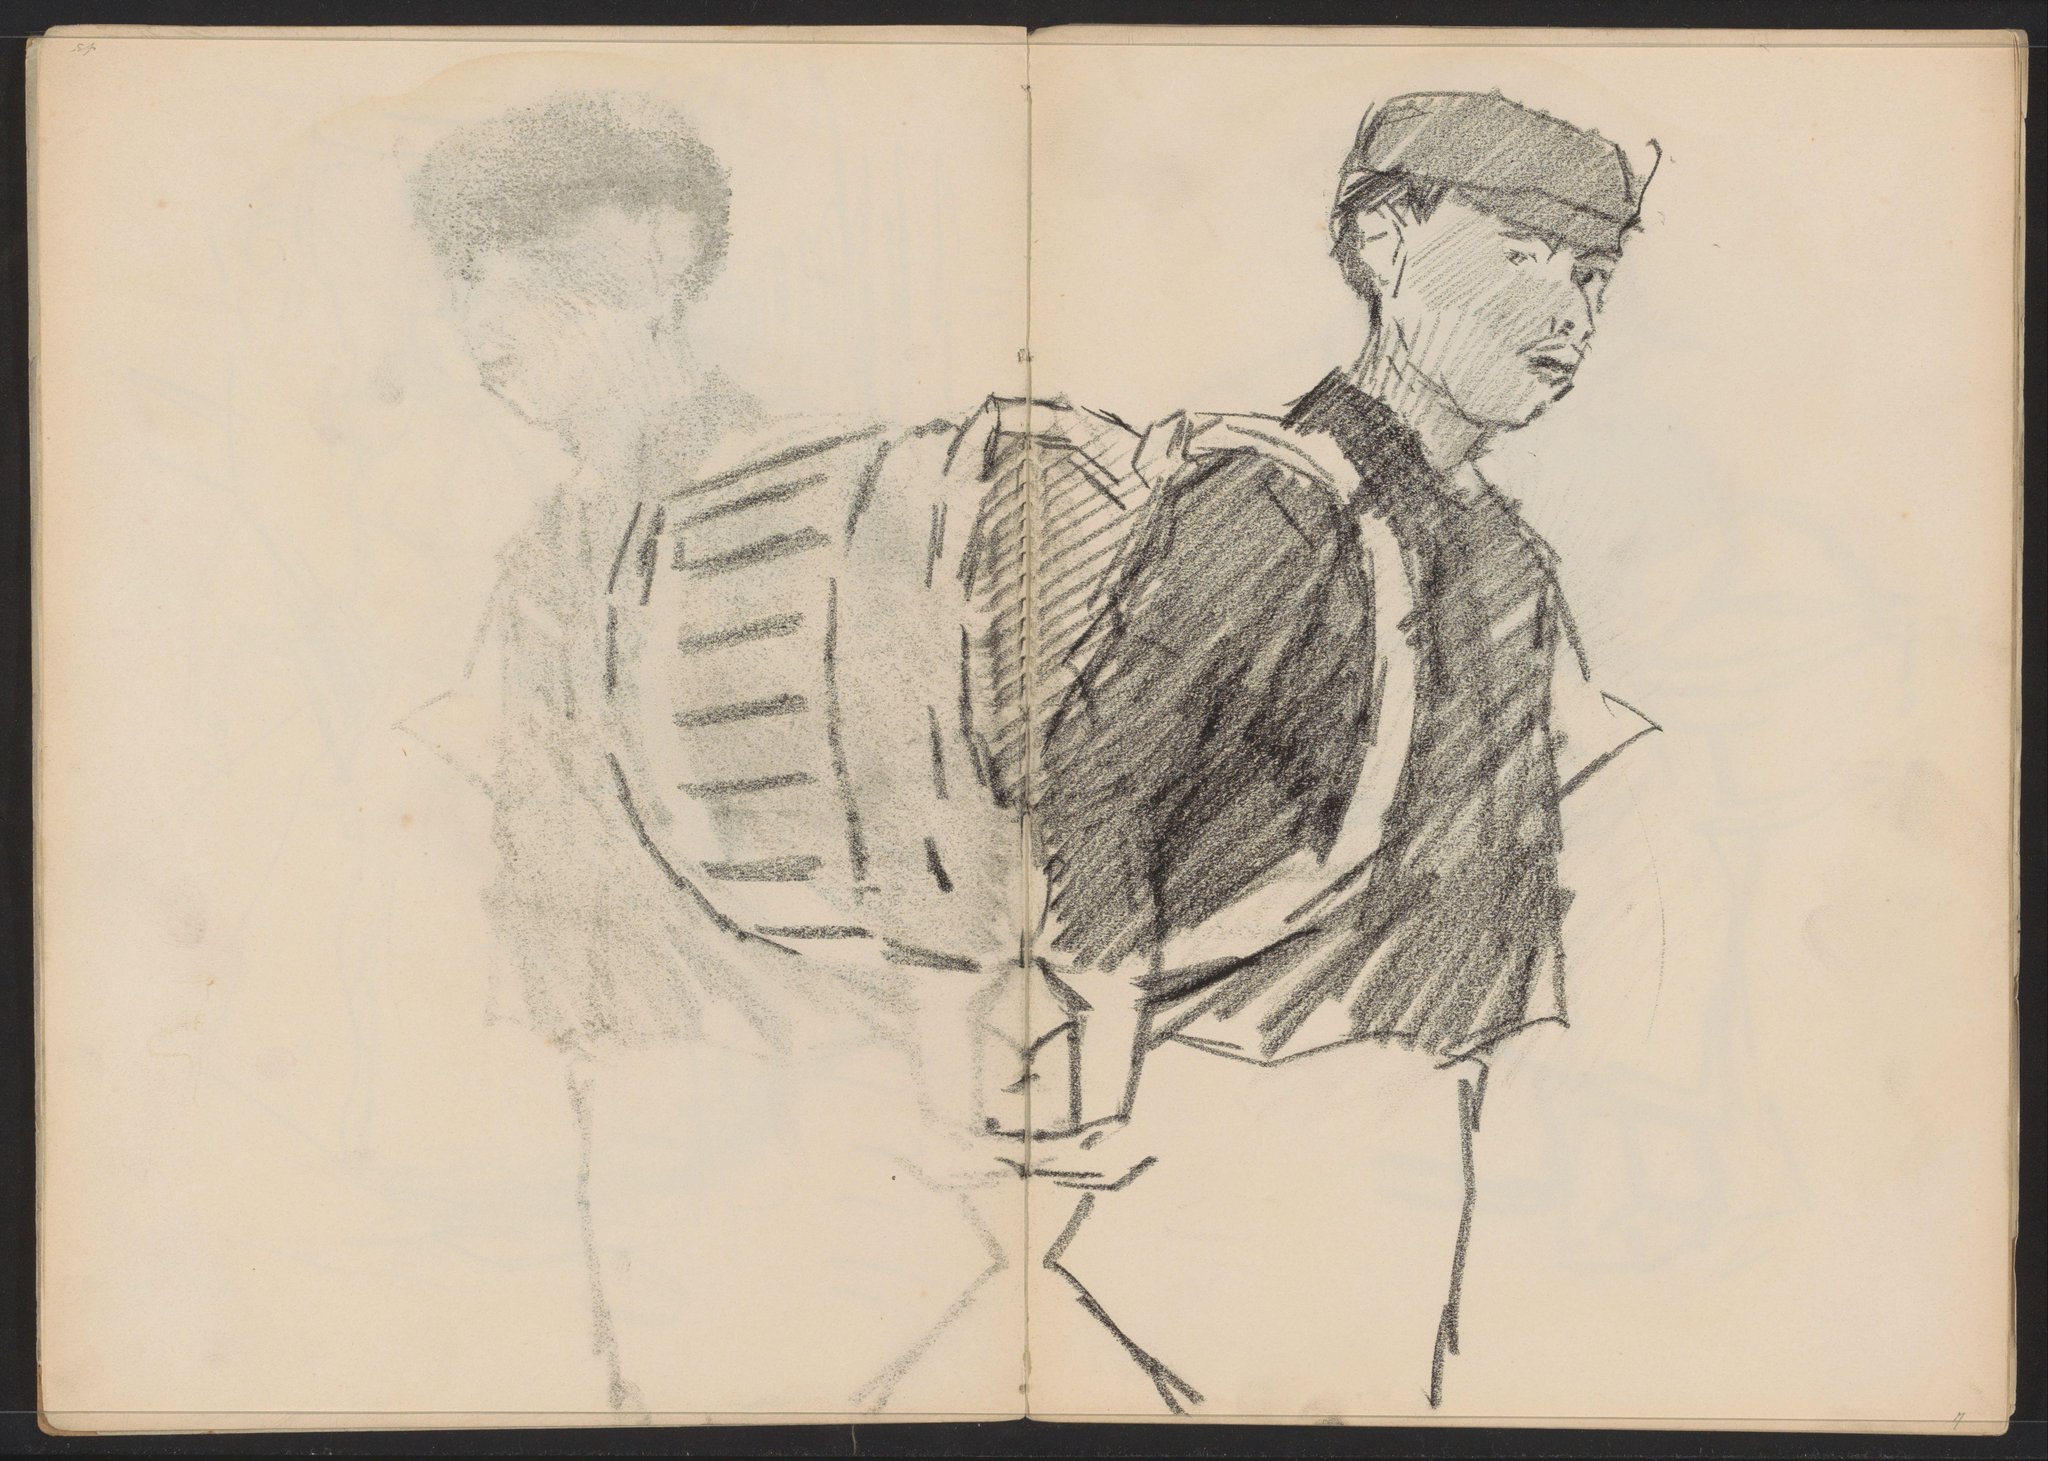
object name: sketchbook leaf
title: Jonge man met een mand op zijn rug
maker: isaac israels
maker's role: draughtsman, painter, print maker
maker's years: 1865-1934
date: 1886-1934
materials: chalk, paper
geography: amsterdam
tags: youth, adolescent, carrying something in basket, bag, rucksack, etc.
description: Blad 6 verso en blad 7 recto uit schetsboek LXVI-B met 25 bladen.